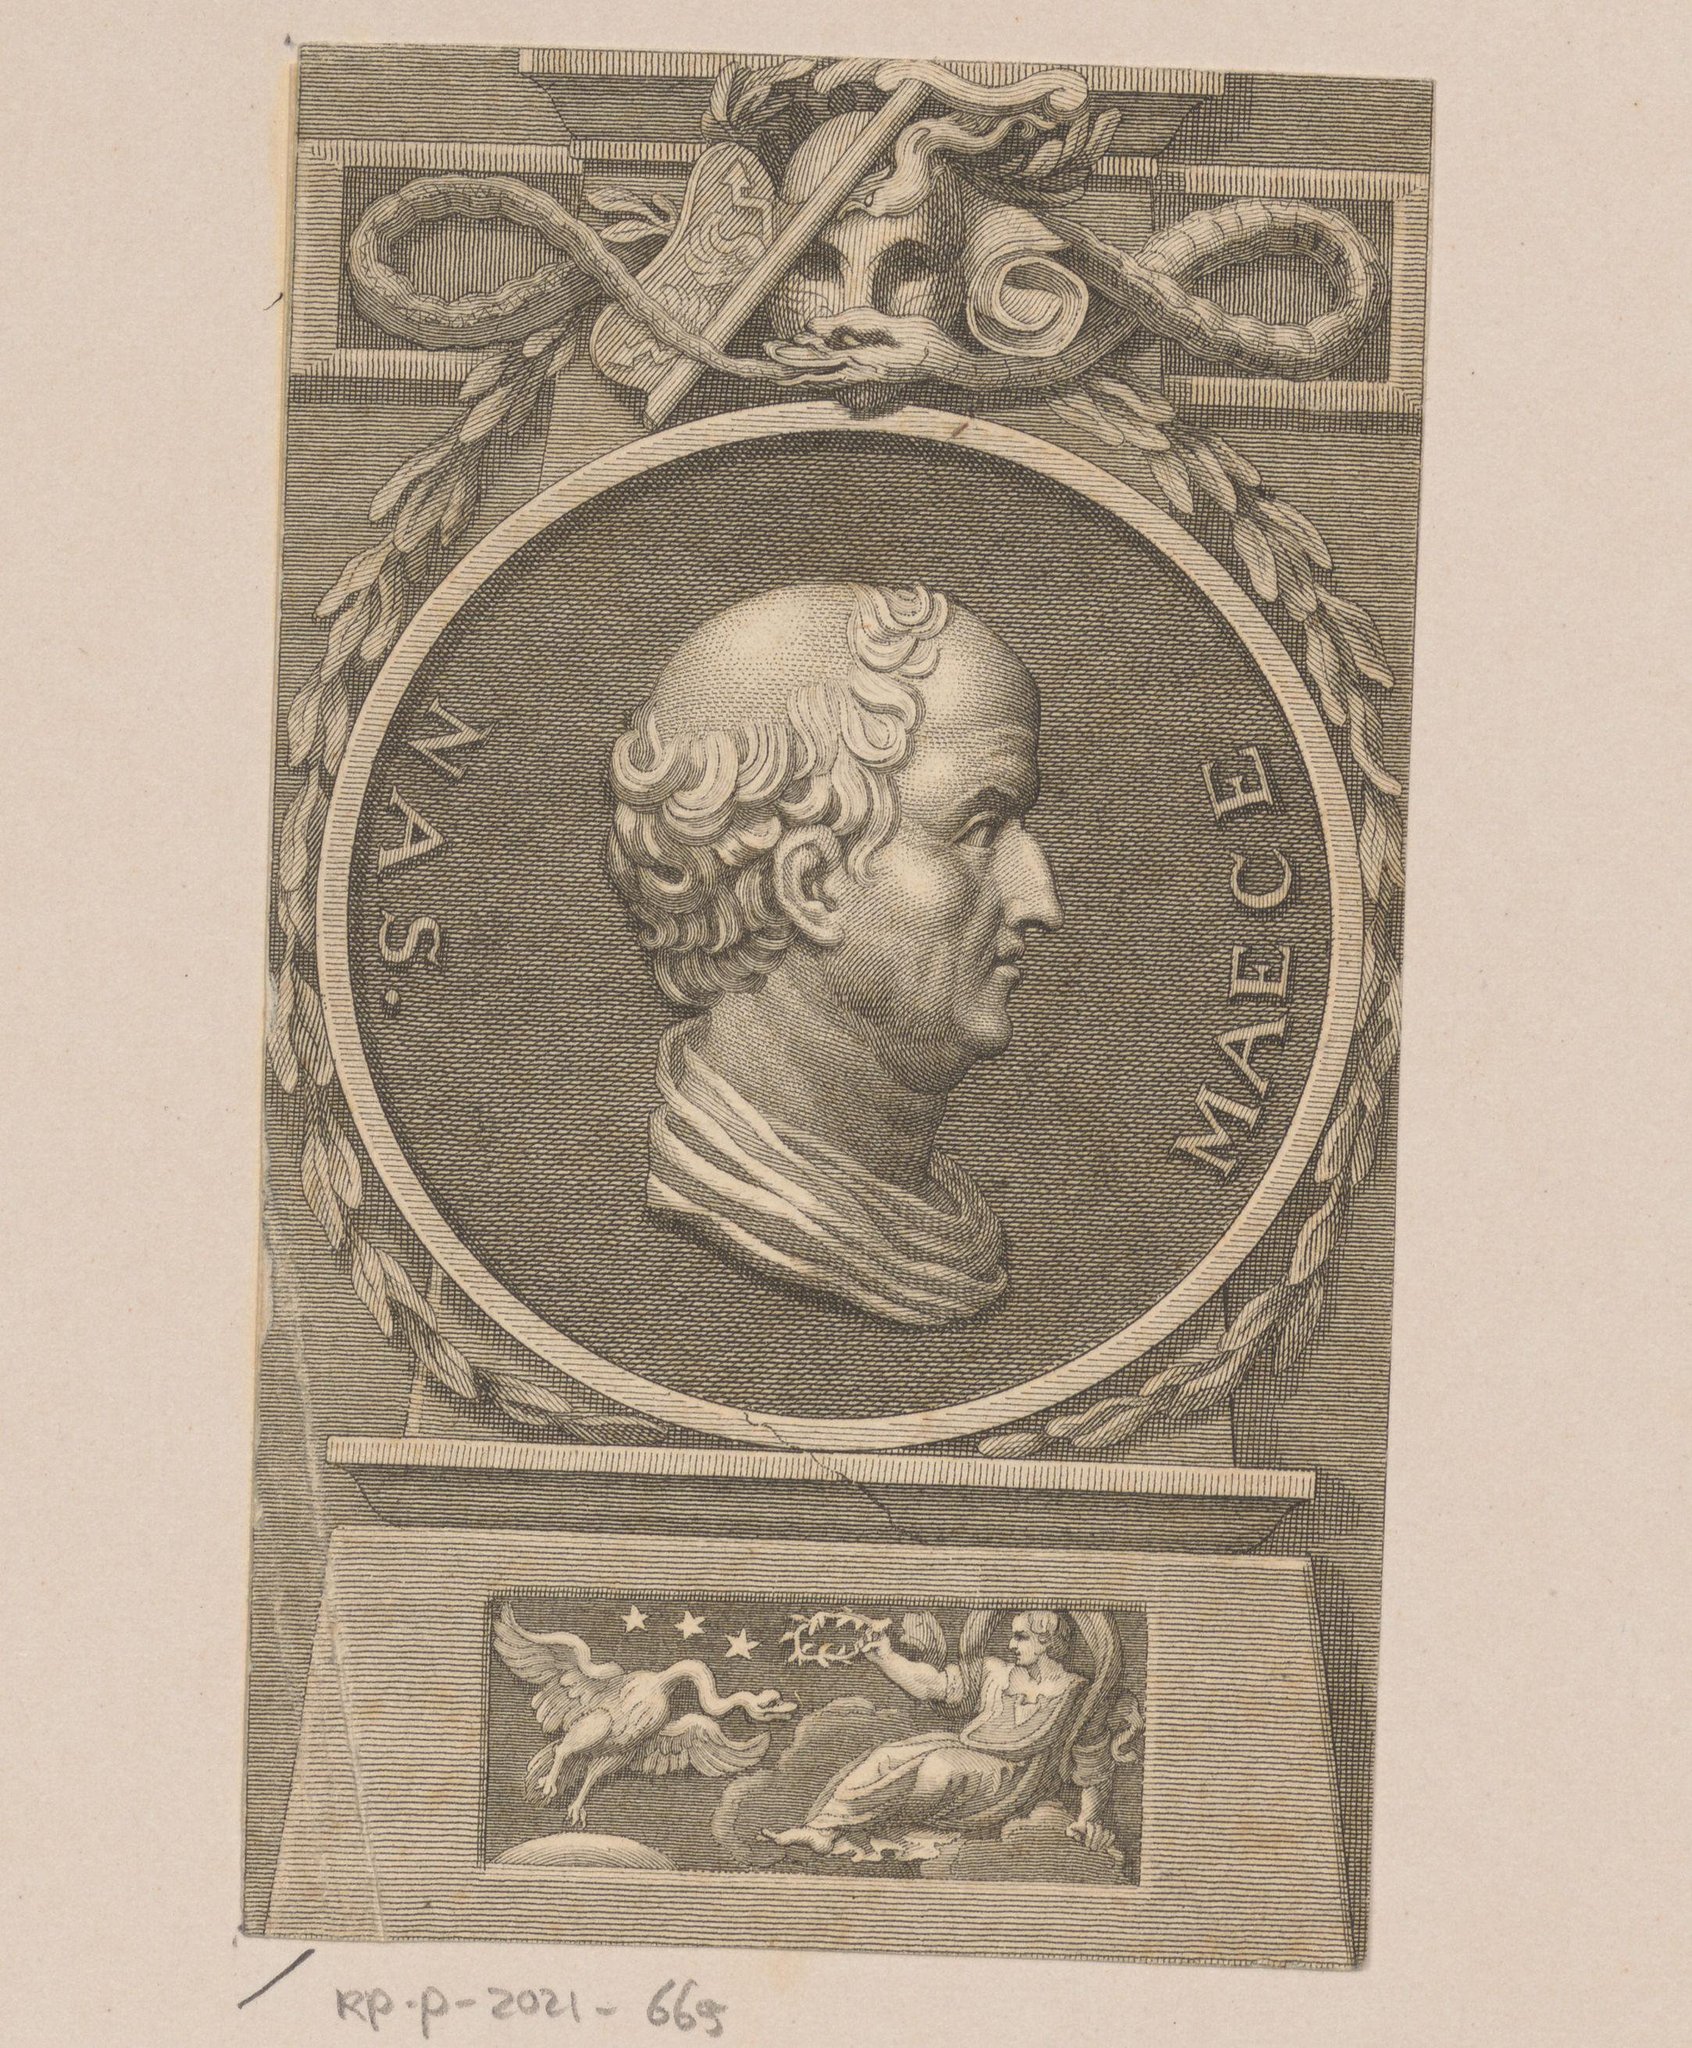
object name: print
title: Portret van Gaius Cilnius Maecenas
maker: Anonymous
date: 1650-1750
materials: paper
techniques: engraving, etching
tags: jupiter, in the shape of a swan, and leda, historical persons